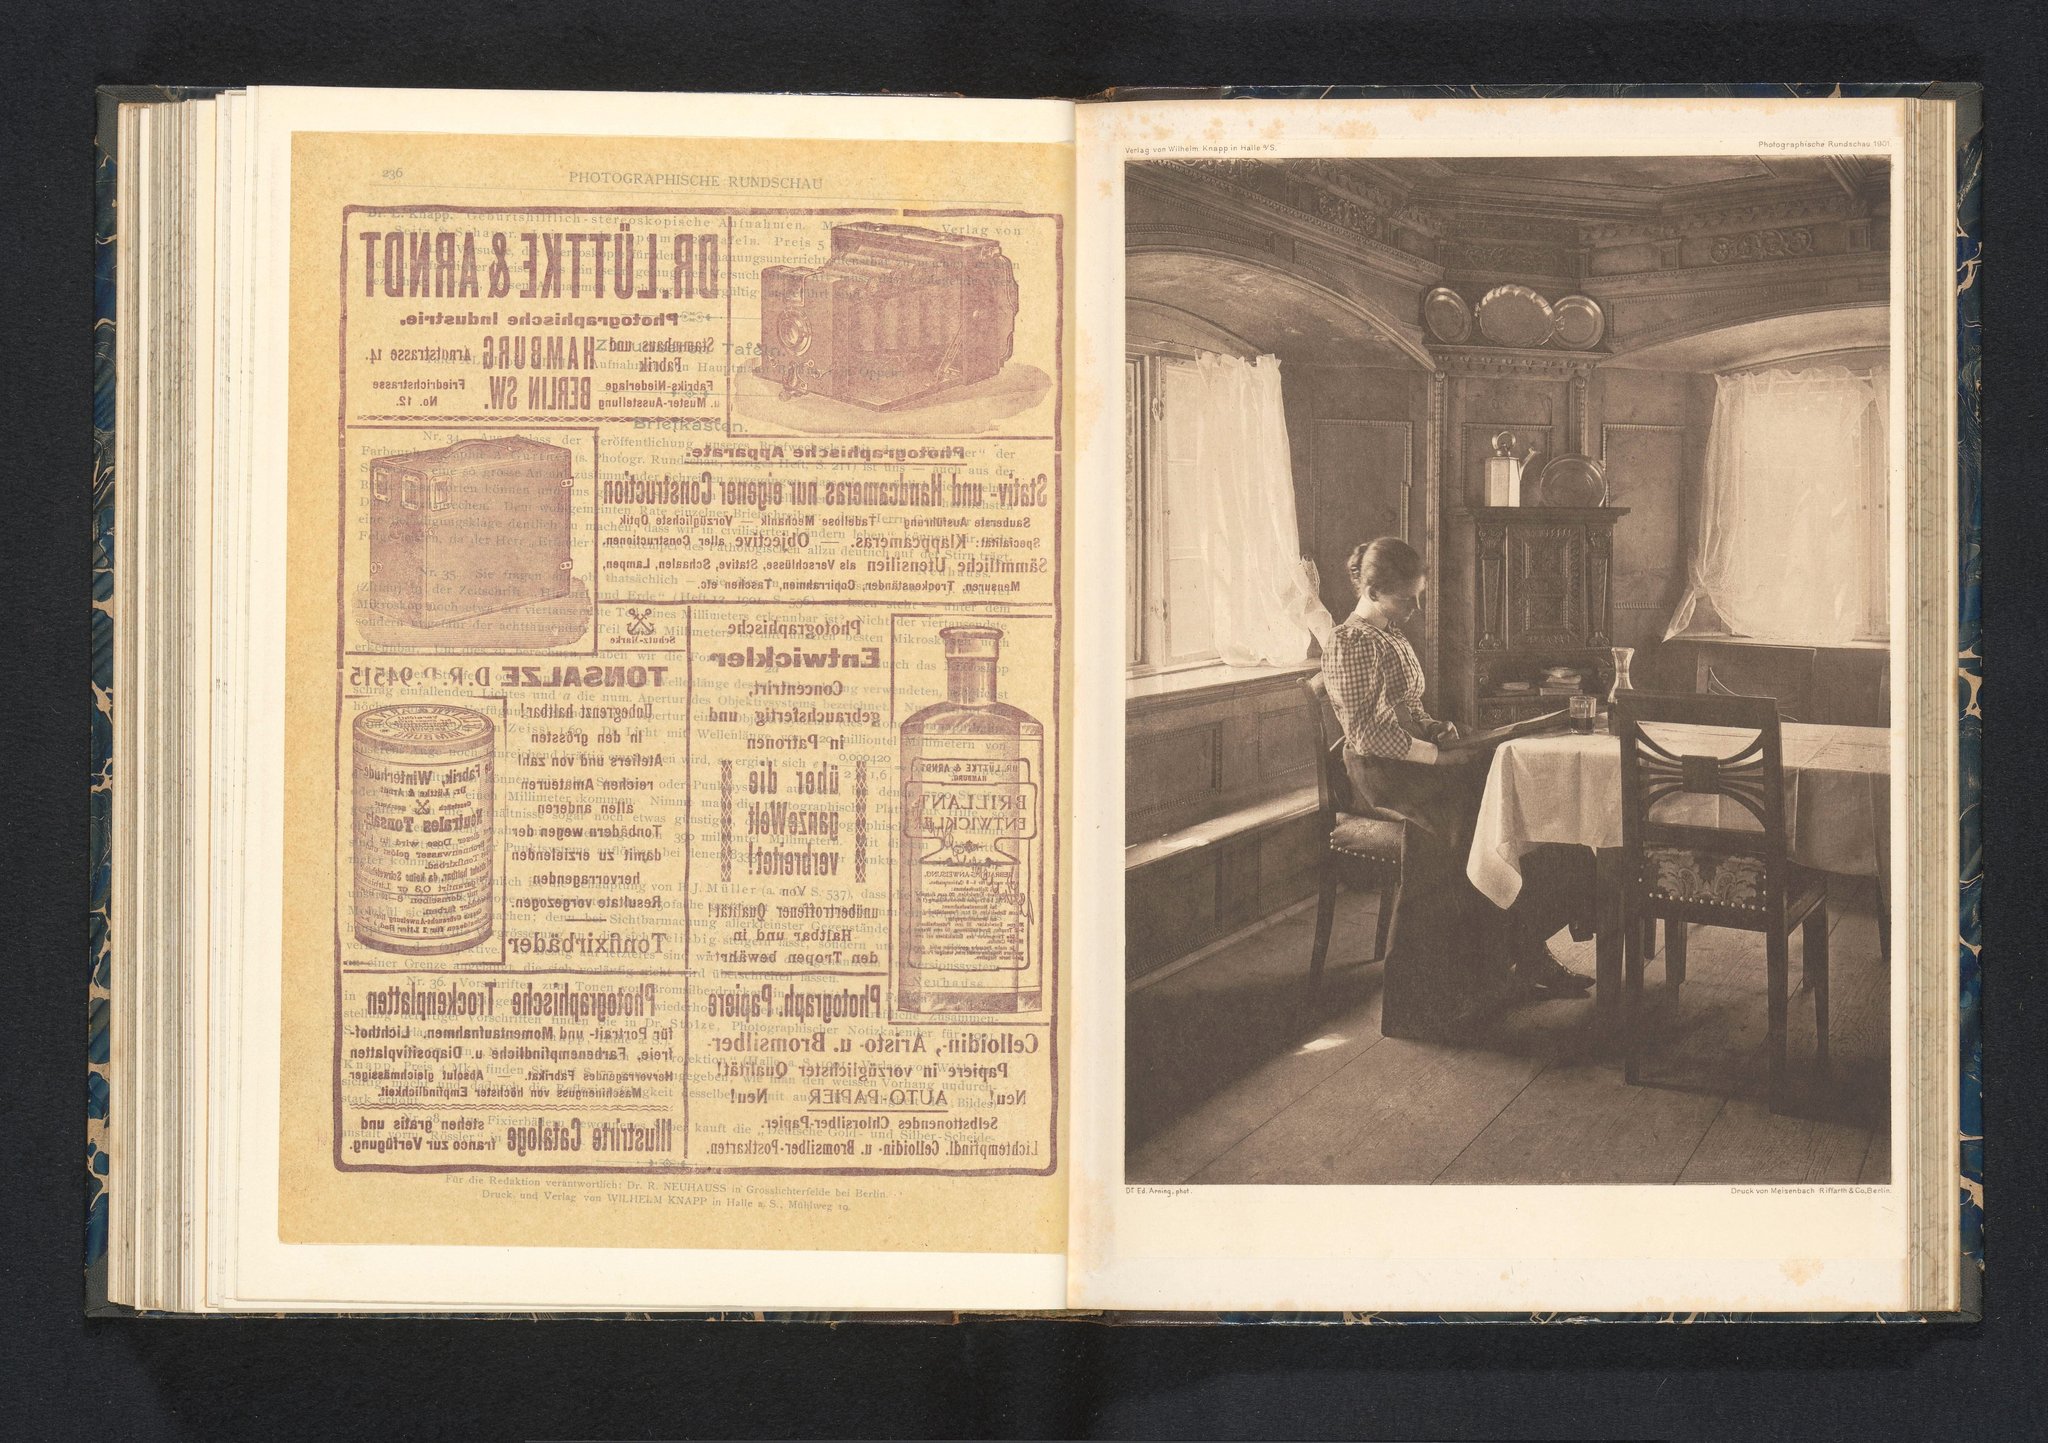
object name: page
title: Portret van een onbekende lezende vrouw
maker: eduard arning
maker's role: fotograaf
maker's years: 1855-1936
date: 1896-1901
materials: paper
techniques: photoaquatint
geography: halle an der saale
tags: reading, historical persons not known by name - bb - woman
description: Prent tegenover pagina 236, achter semi-transparante omslag met reclameboodschap.